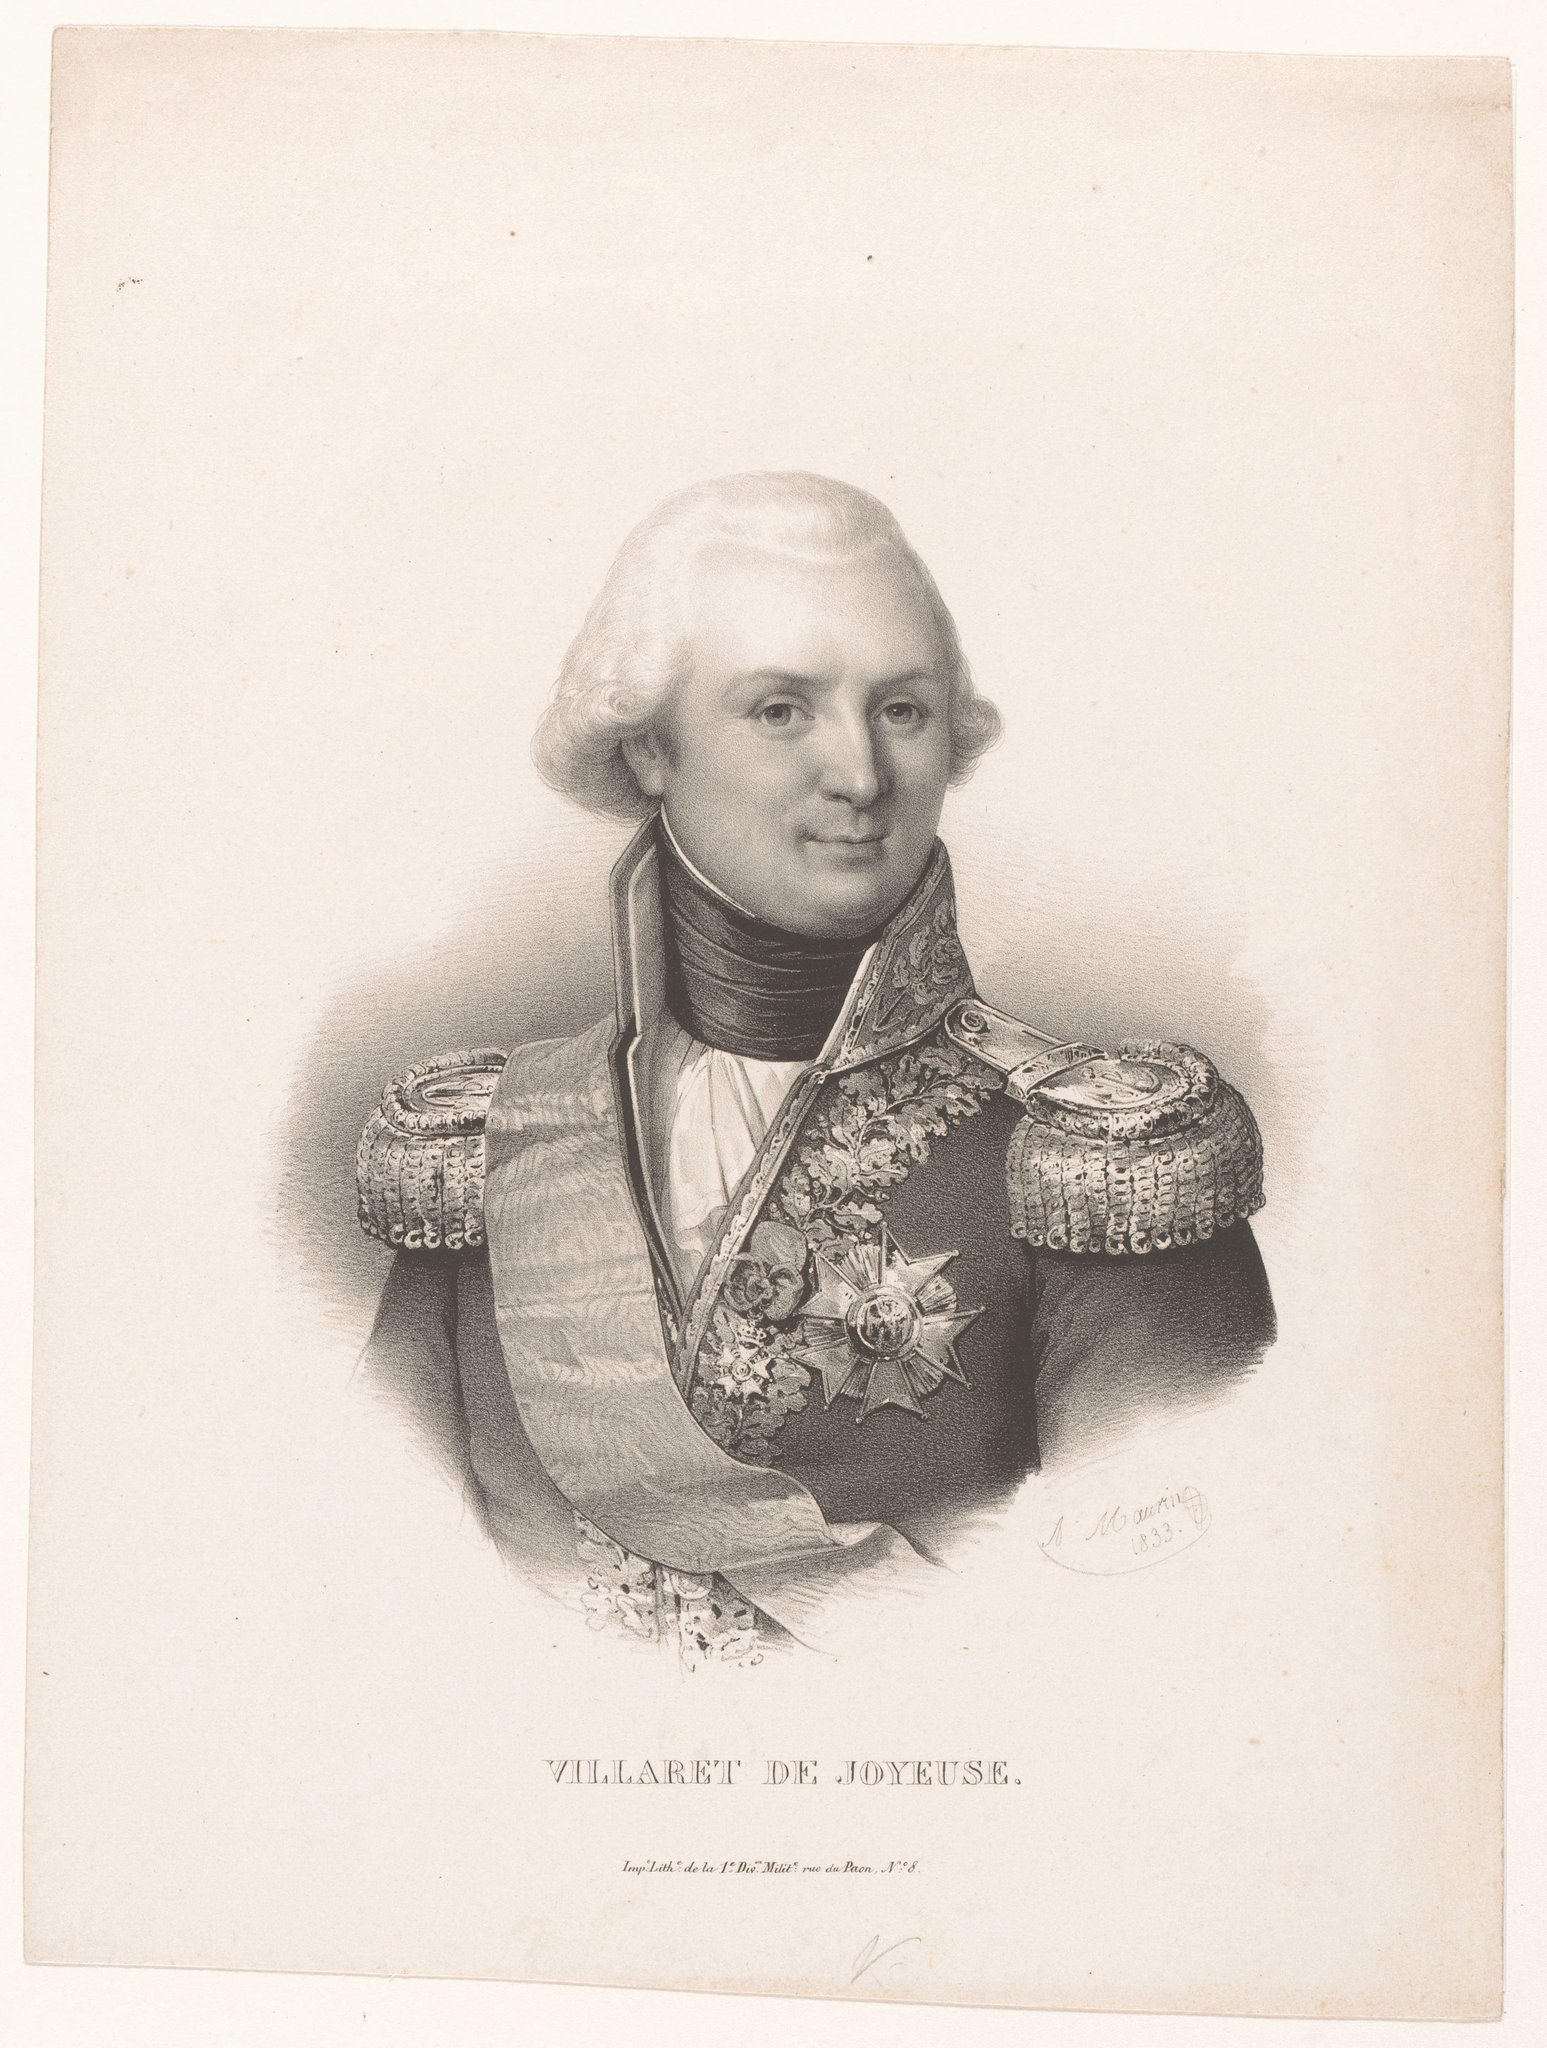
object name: print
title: Villaret de Joyeuse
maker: antoine maurin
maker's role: print maker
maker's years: 1793-1860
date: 1833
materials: paper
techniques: lithograph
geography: paris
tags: historical persons, officer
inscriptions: collector's mark: Lugt 2228